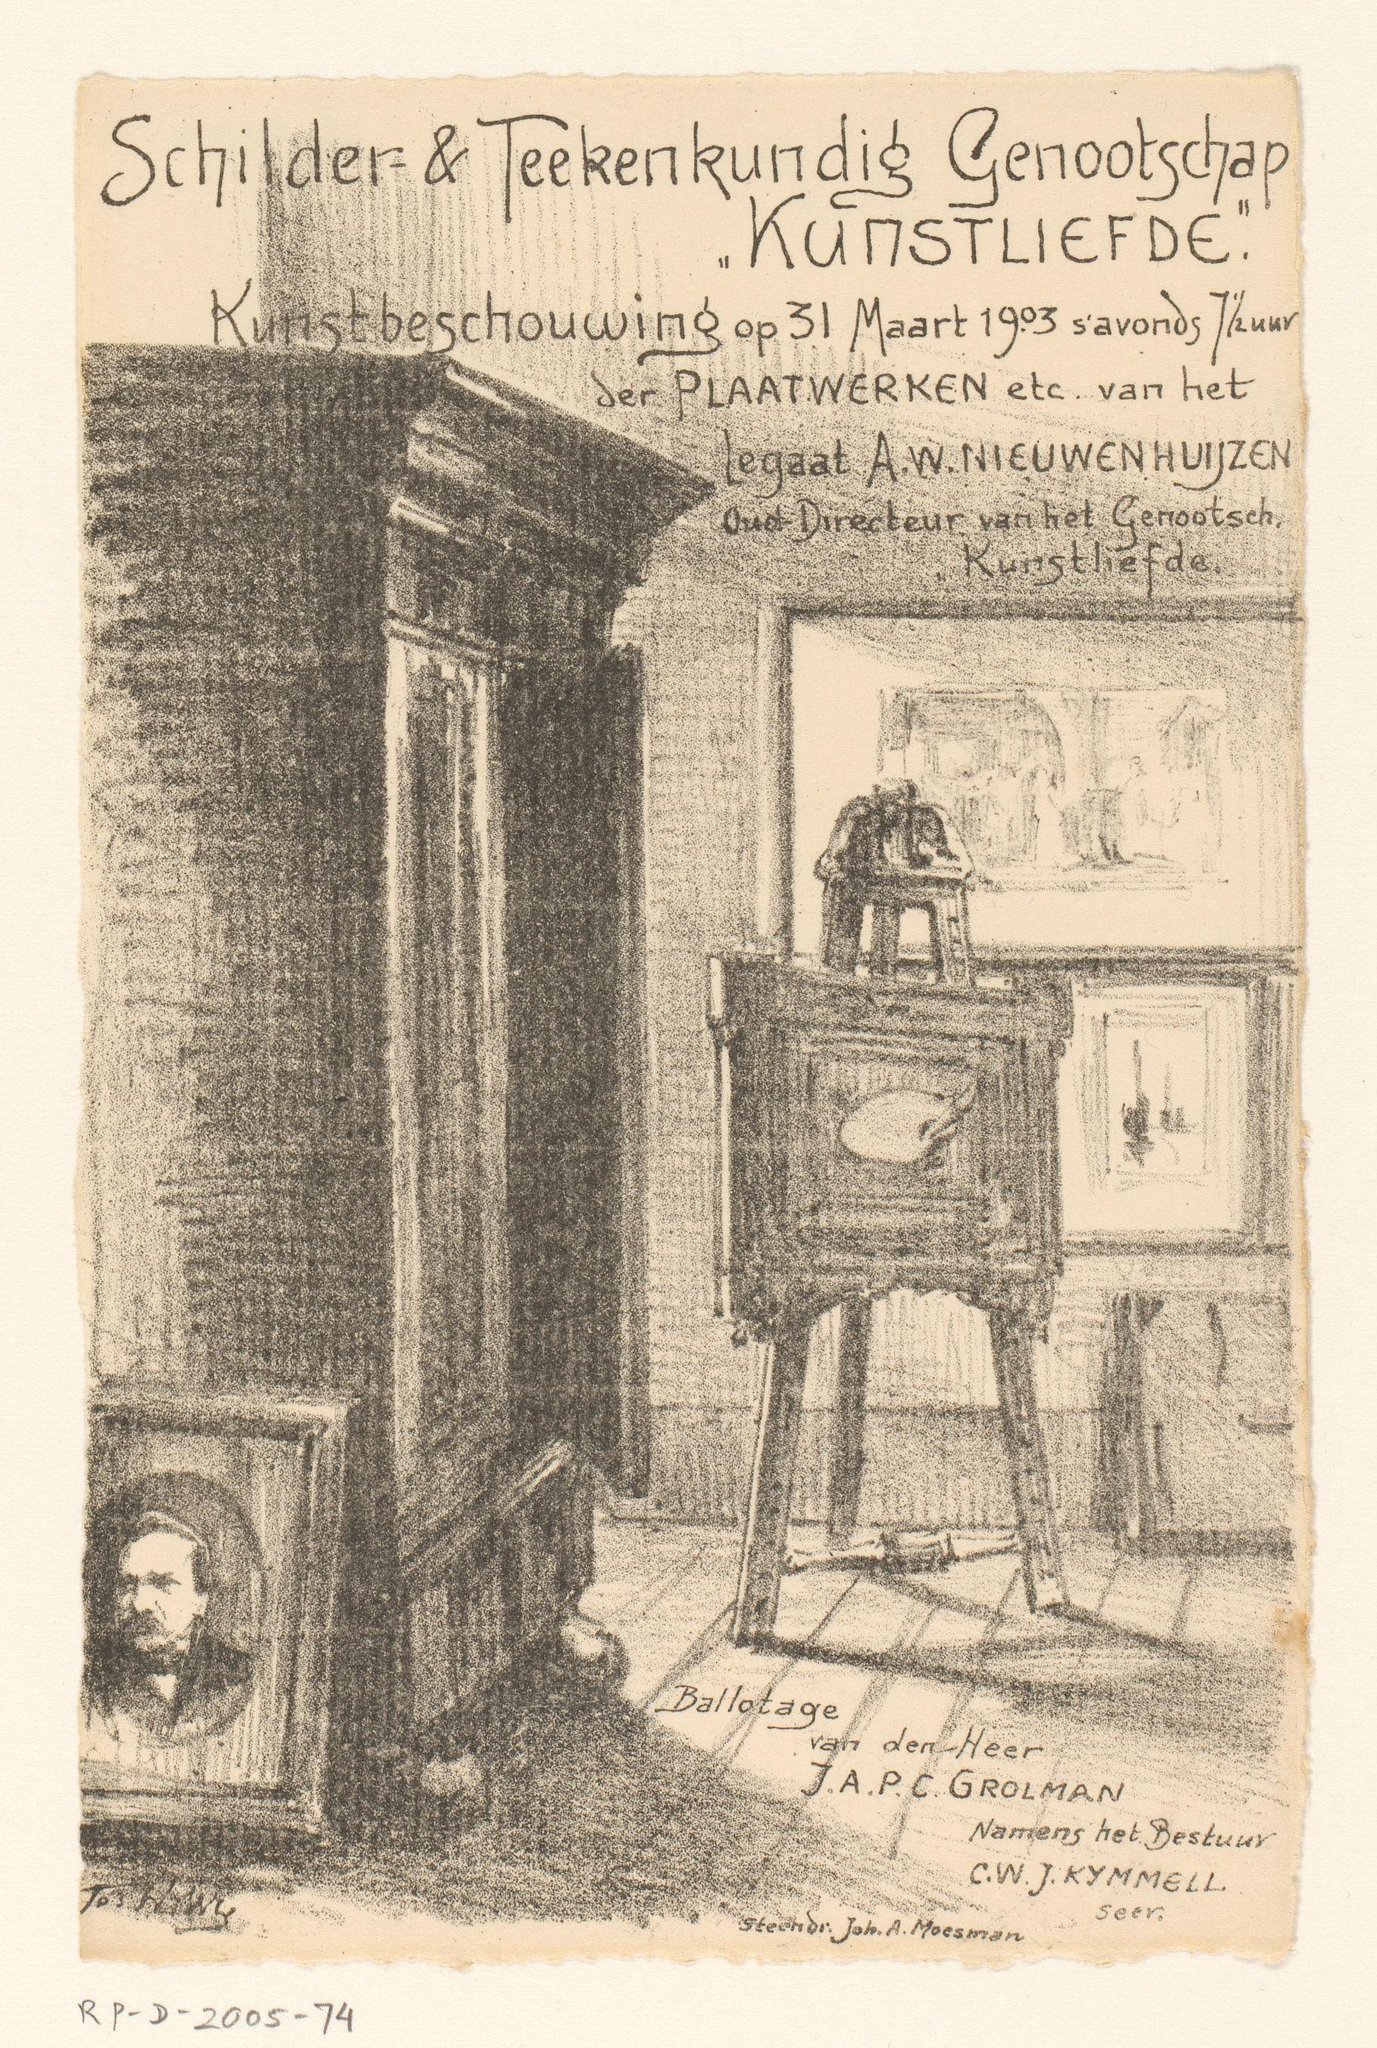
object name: print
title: Uitnodiging van Schilder- en Teekenkundig Genootschap "Kunstliefde" voor een kunstbeschouwing, 31 maart 1903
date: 1903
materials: paper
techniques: lithograph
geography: utrecht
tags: utrecht, print maker, draughtsman, adrianus wilhelmus nieuwenhuyzen, criticizing and discussing art, art criticism, circle, club of artists, drawing-room, 'salon', collecting and exhibiting products of the fine arts, picture, painting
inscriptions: collector's mark: Lugt 2228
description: Interieur met kast en schilderij op ezel. Uitnodiging van Schilder- en Teekenkundig Genootschap "Kunstliefde" voor een kunstbeschouwing op 31 maart 1903 van 'plaatwerken etc. van het legaat A.W. Nieuwenhuijzen, Oud-Directeur van het Genootsch. Kunstliefde'.